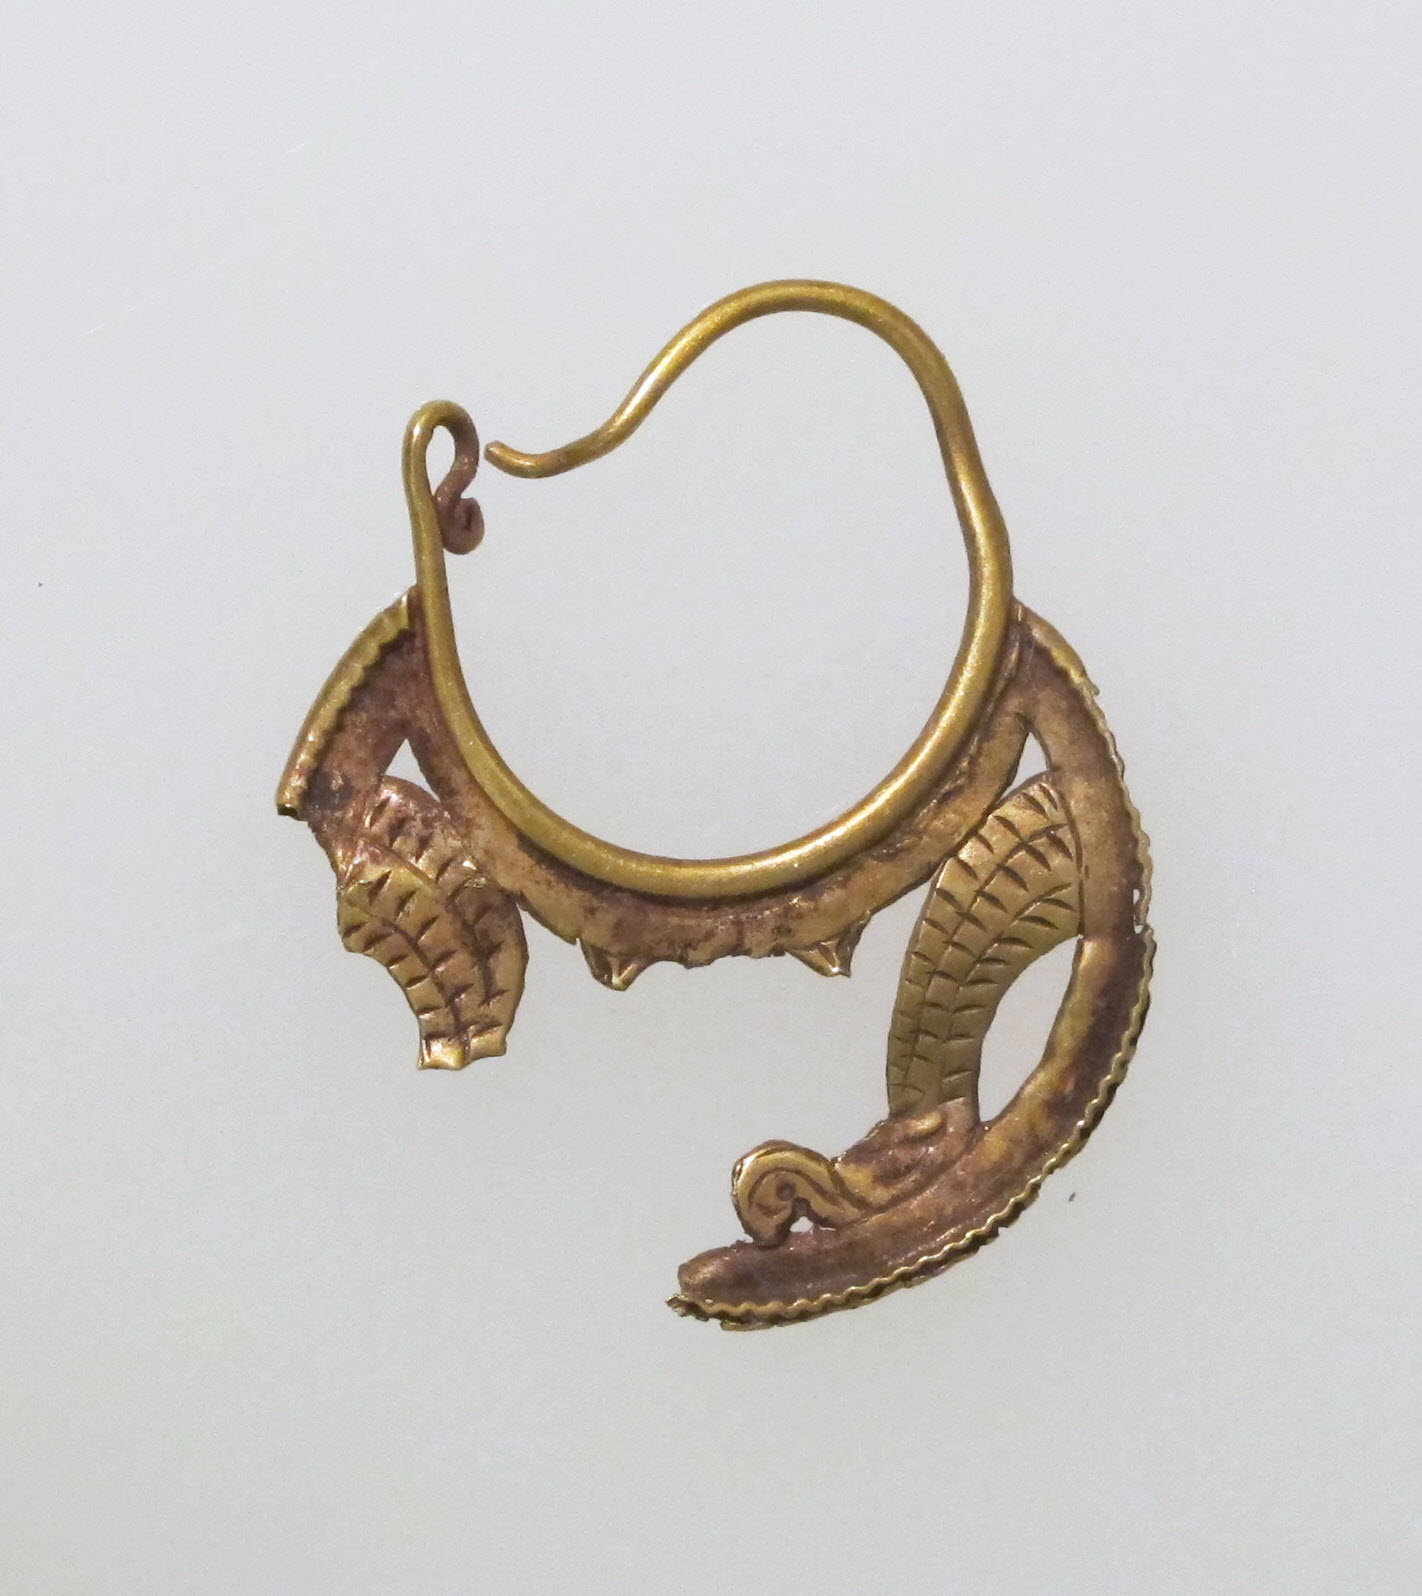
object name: earring, crescent shaped, byzantine style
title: Earring, crescent-shaped, Byzantine style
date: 7000 BCE-330 CE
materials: gold